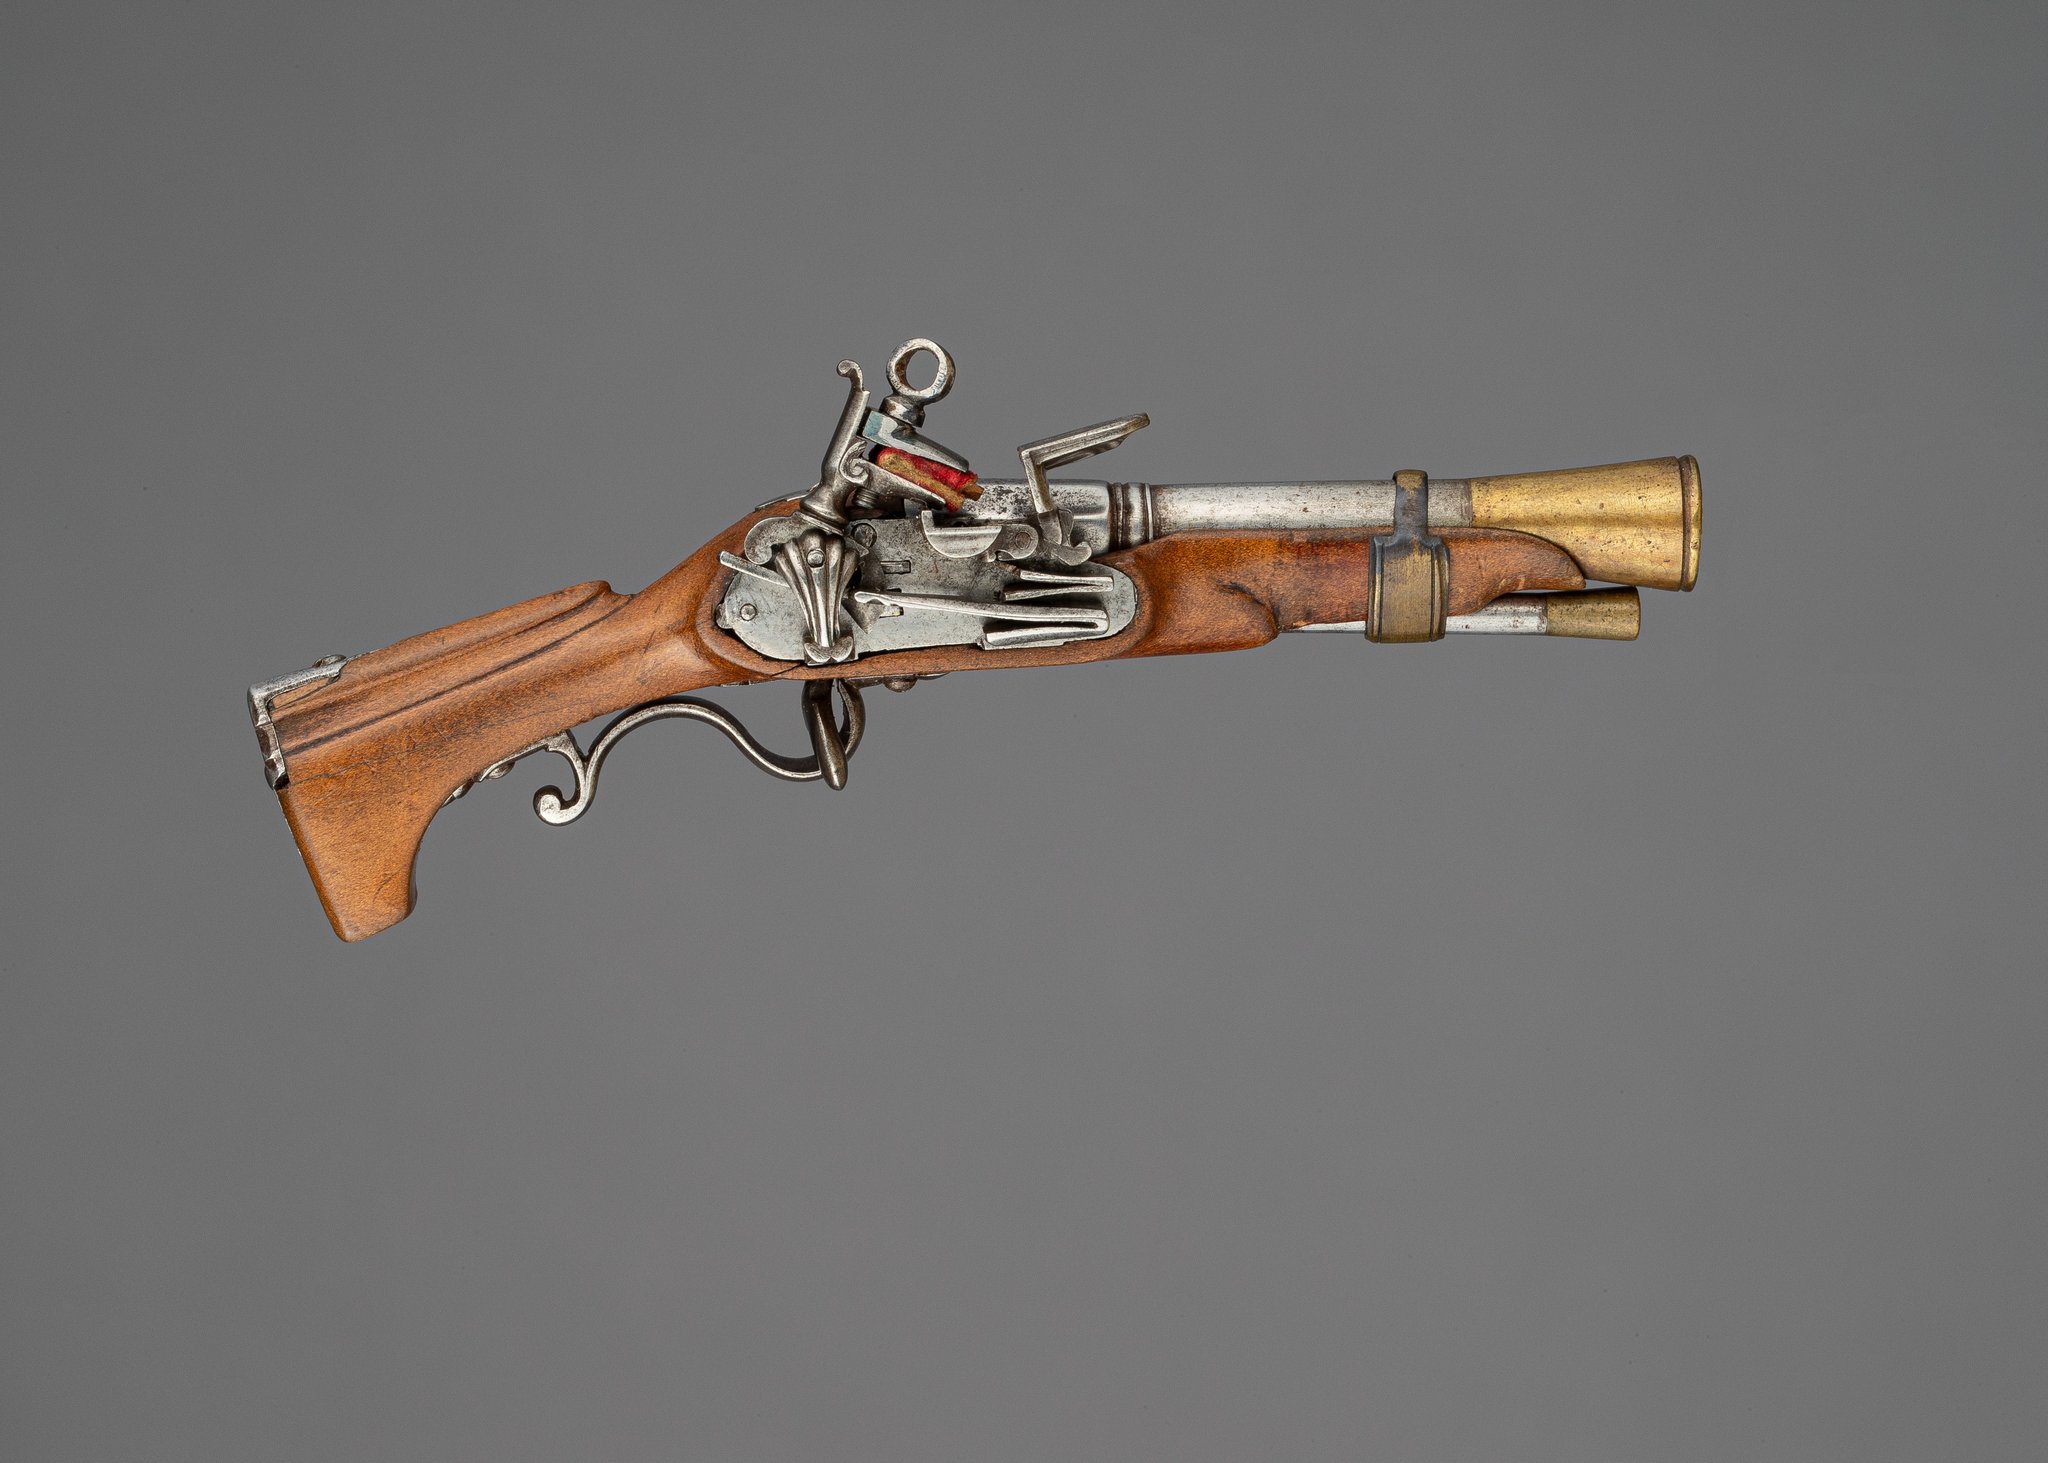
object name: model of a miquelet blunderbuss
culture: spanish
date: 1601-1700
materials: copper alloy, steel, wood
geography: spain